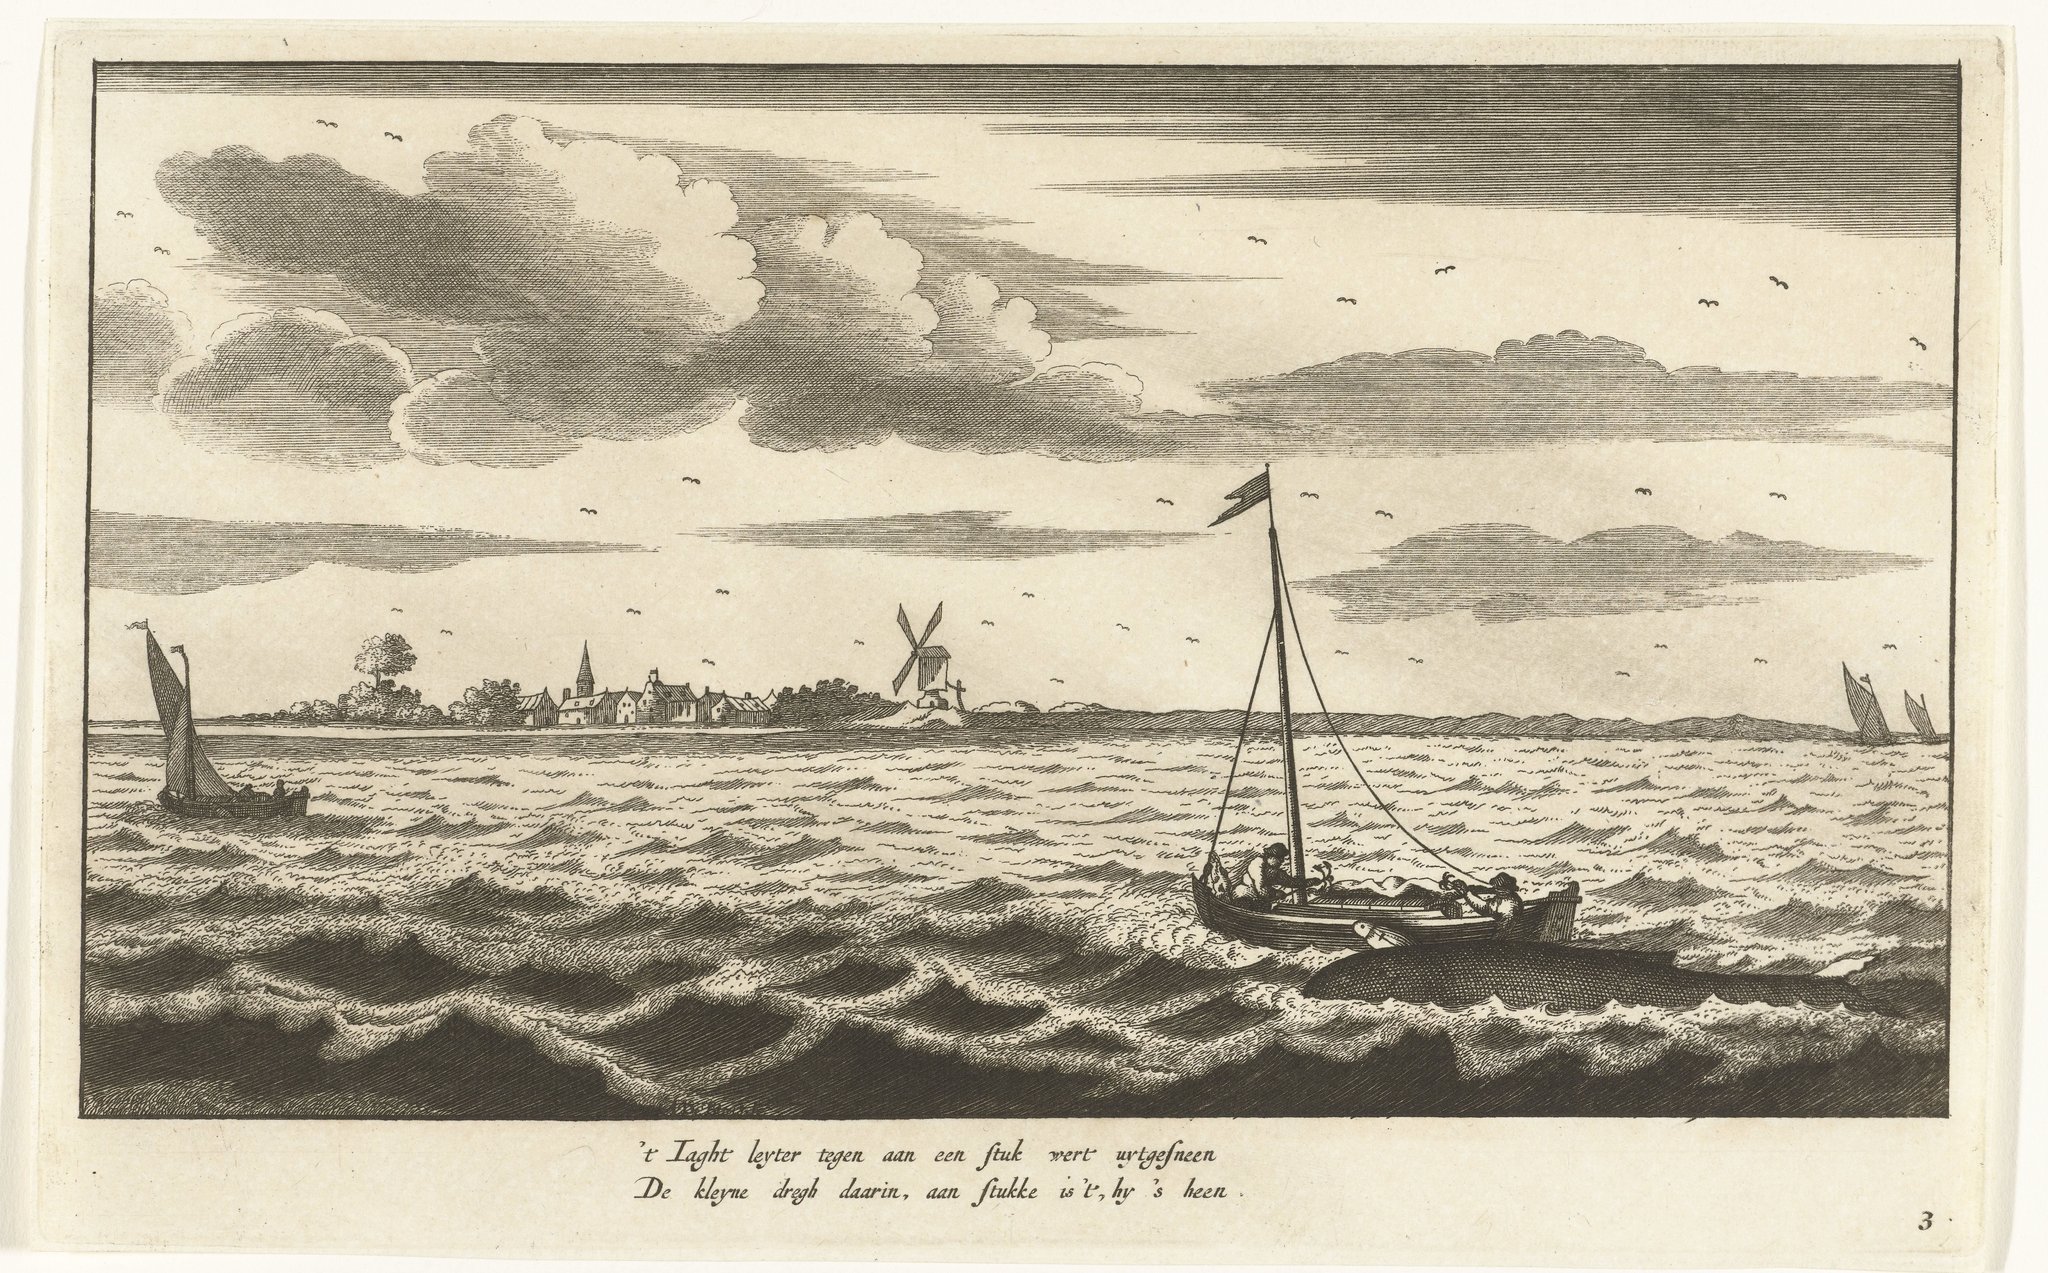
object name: print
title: Zes prenten van het vangen van een walvis bij Sint Annaland in 1682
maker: abraham de blois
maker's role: print maker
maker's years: 1679-1717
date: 1682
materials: paper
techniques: etching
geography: northern netherlands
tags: whale fishery, whaling, swimming mammals: whale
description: De walvis wordt gevangen door de visser Abr. Jansz. van Oelen en zijn zoon. In het onderschrift een vers van 2 regels. Prent nr. 3 in een serie van zes prenten over het vangen van een walvis bij Sint Annaland op het eiland Tholen, 7 oktober 1682.